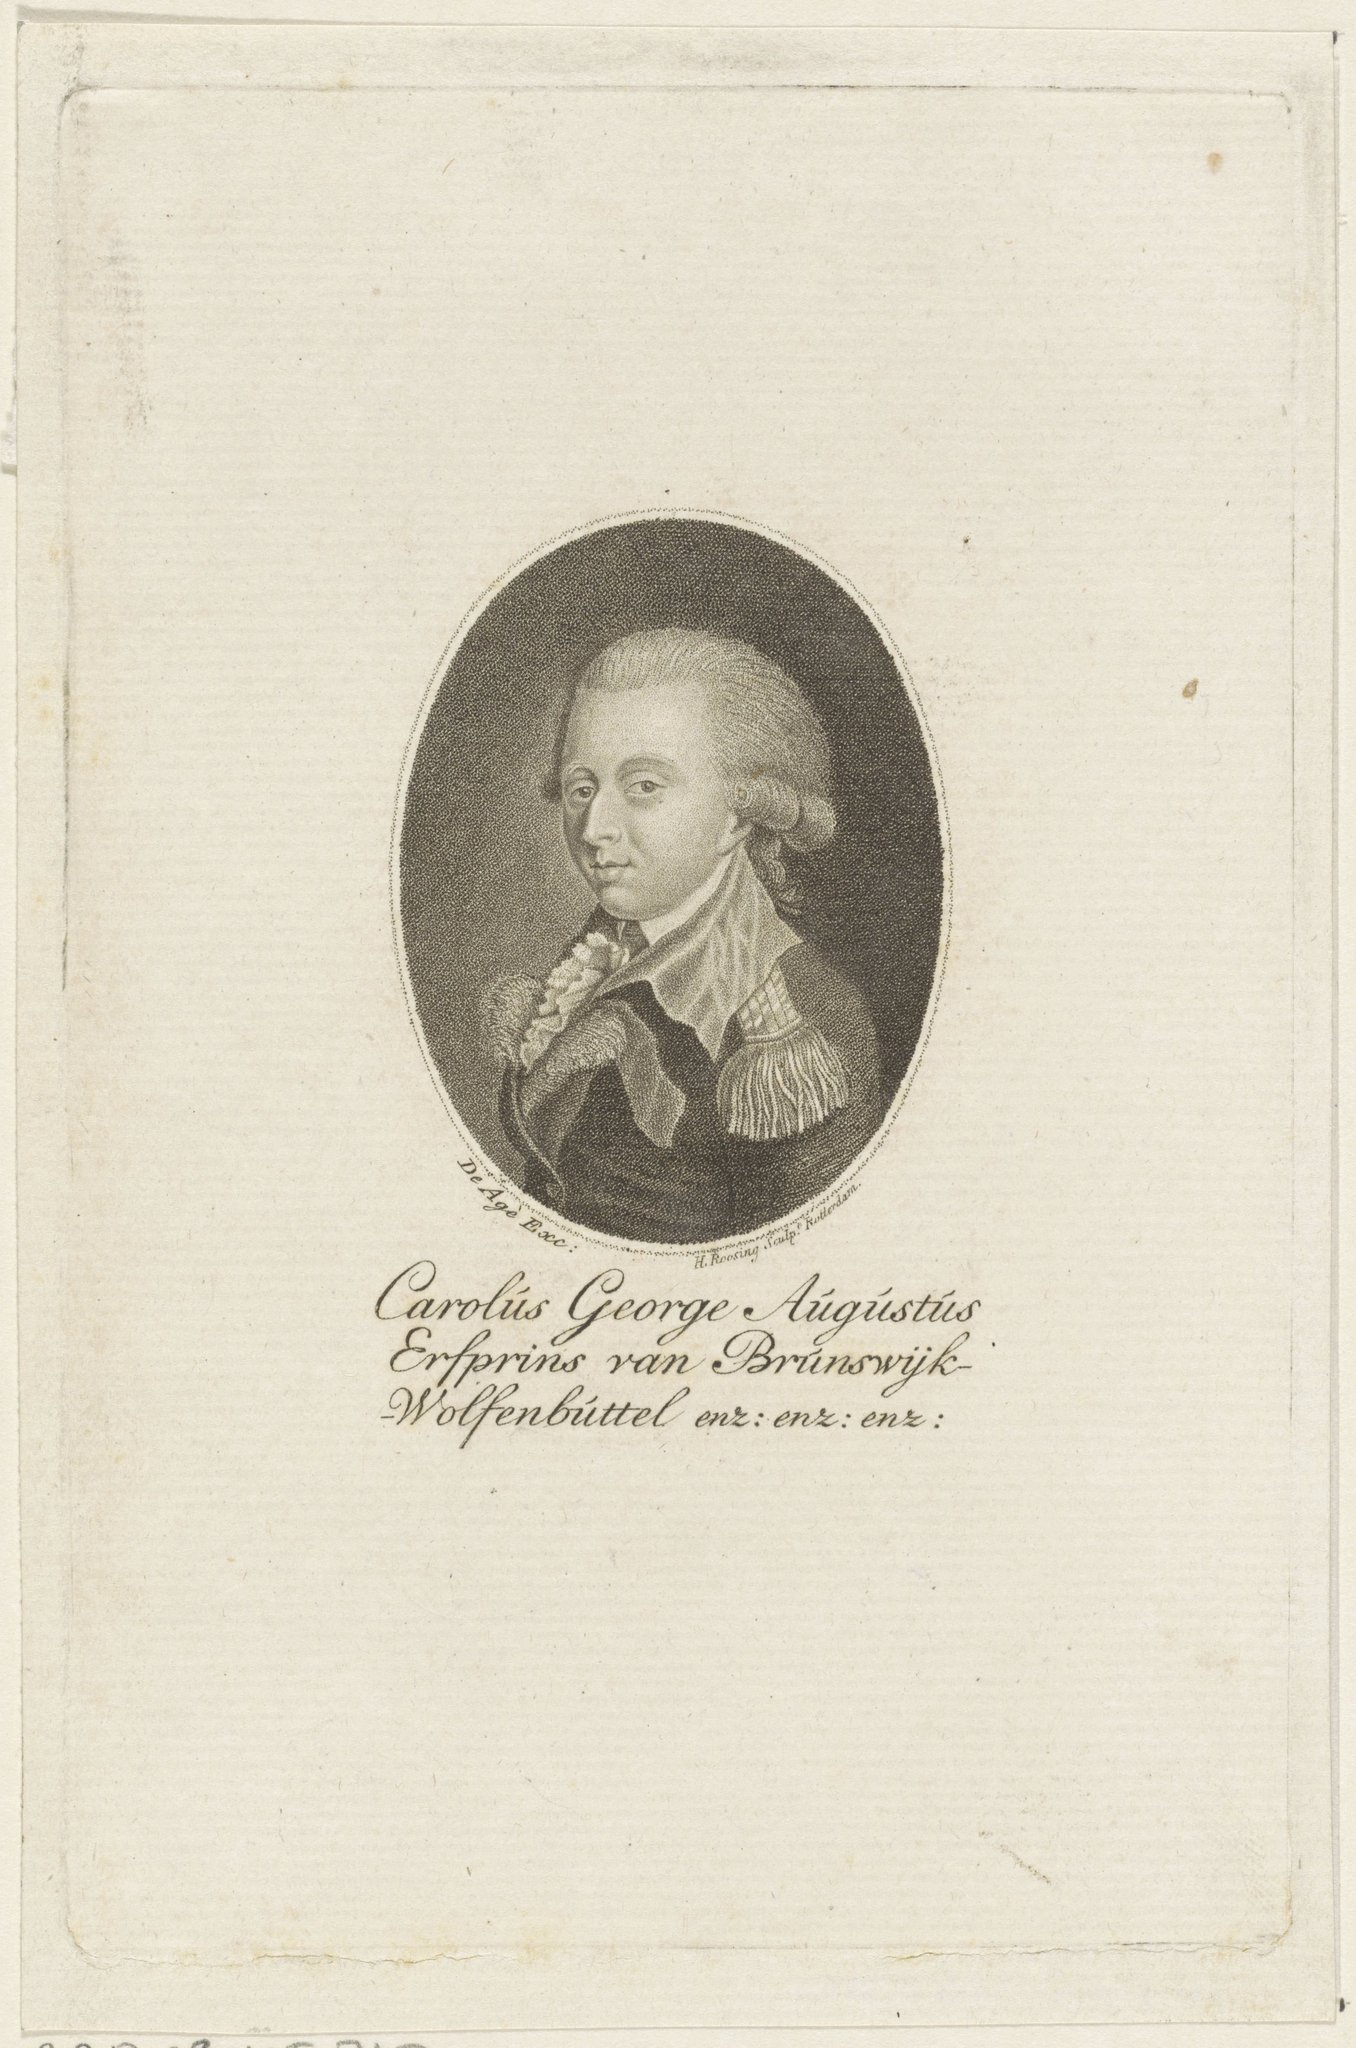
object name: print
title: Portret van Karel van Brunswijk-Wolfenbüttel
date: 1785-1801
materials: paper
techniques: engraving, etching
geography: rotterdam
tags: karel van brunswijk-wolfenbüttel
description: Portret van Karel in een ovaal. In de ondermarge zijn naam en titels.